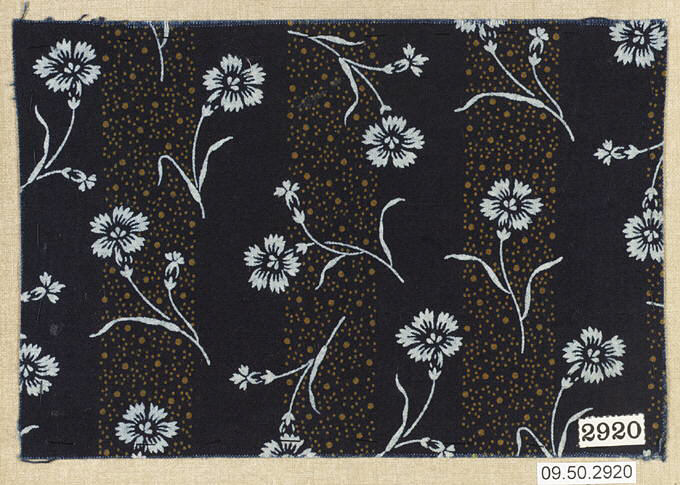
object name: piece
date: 1801-1900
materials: cotton